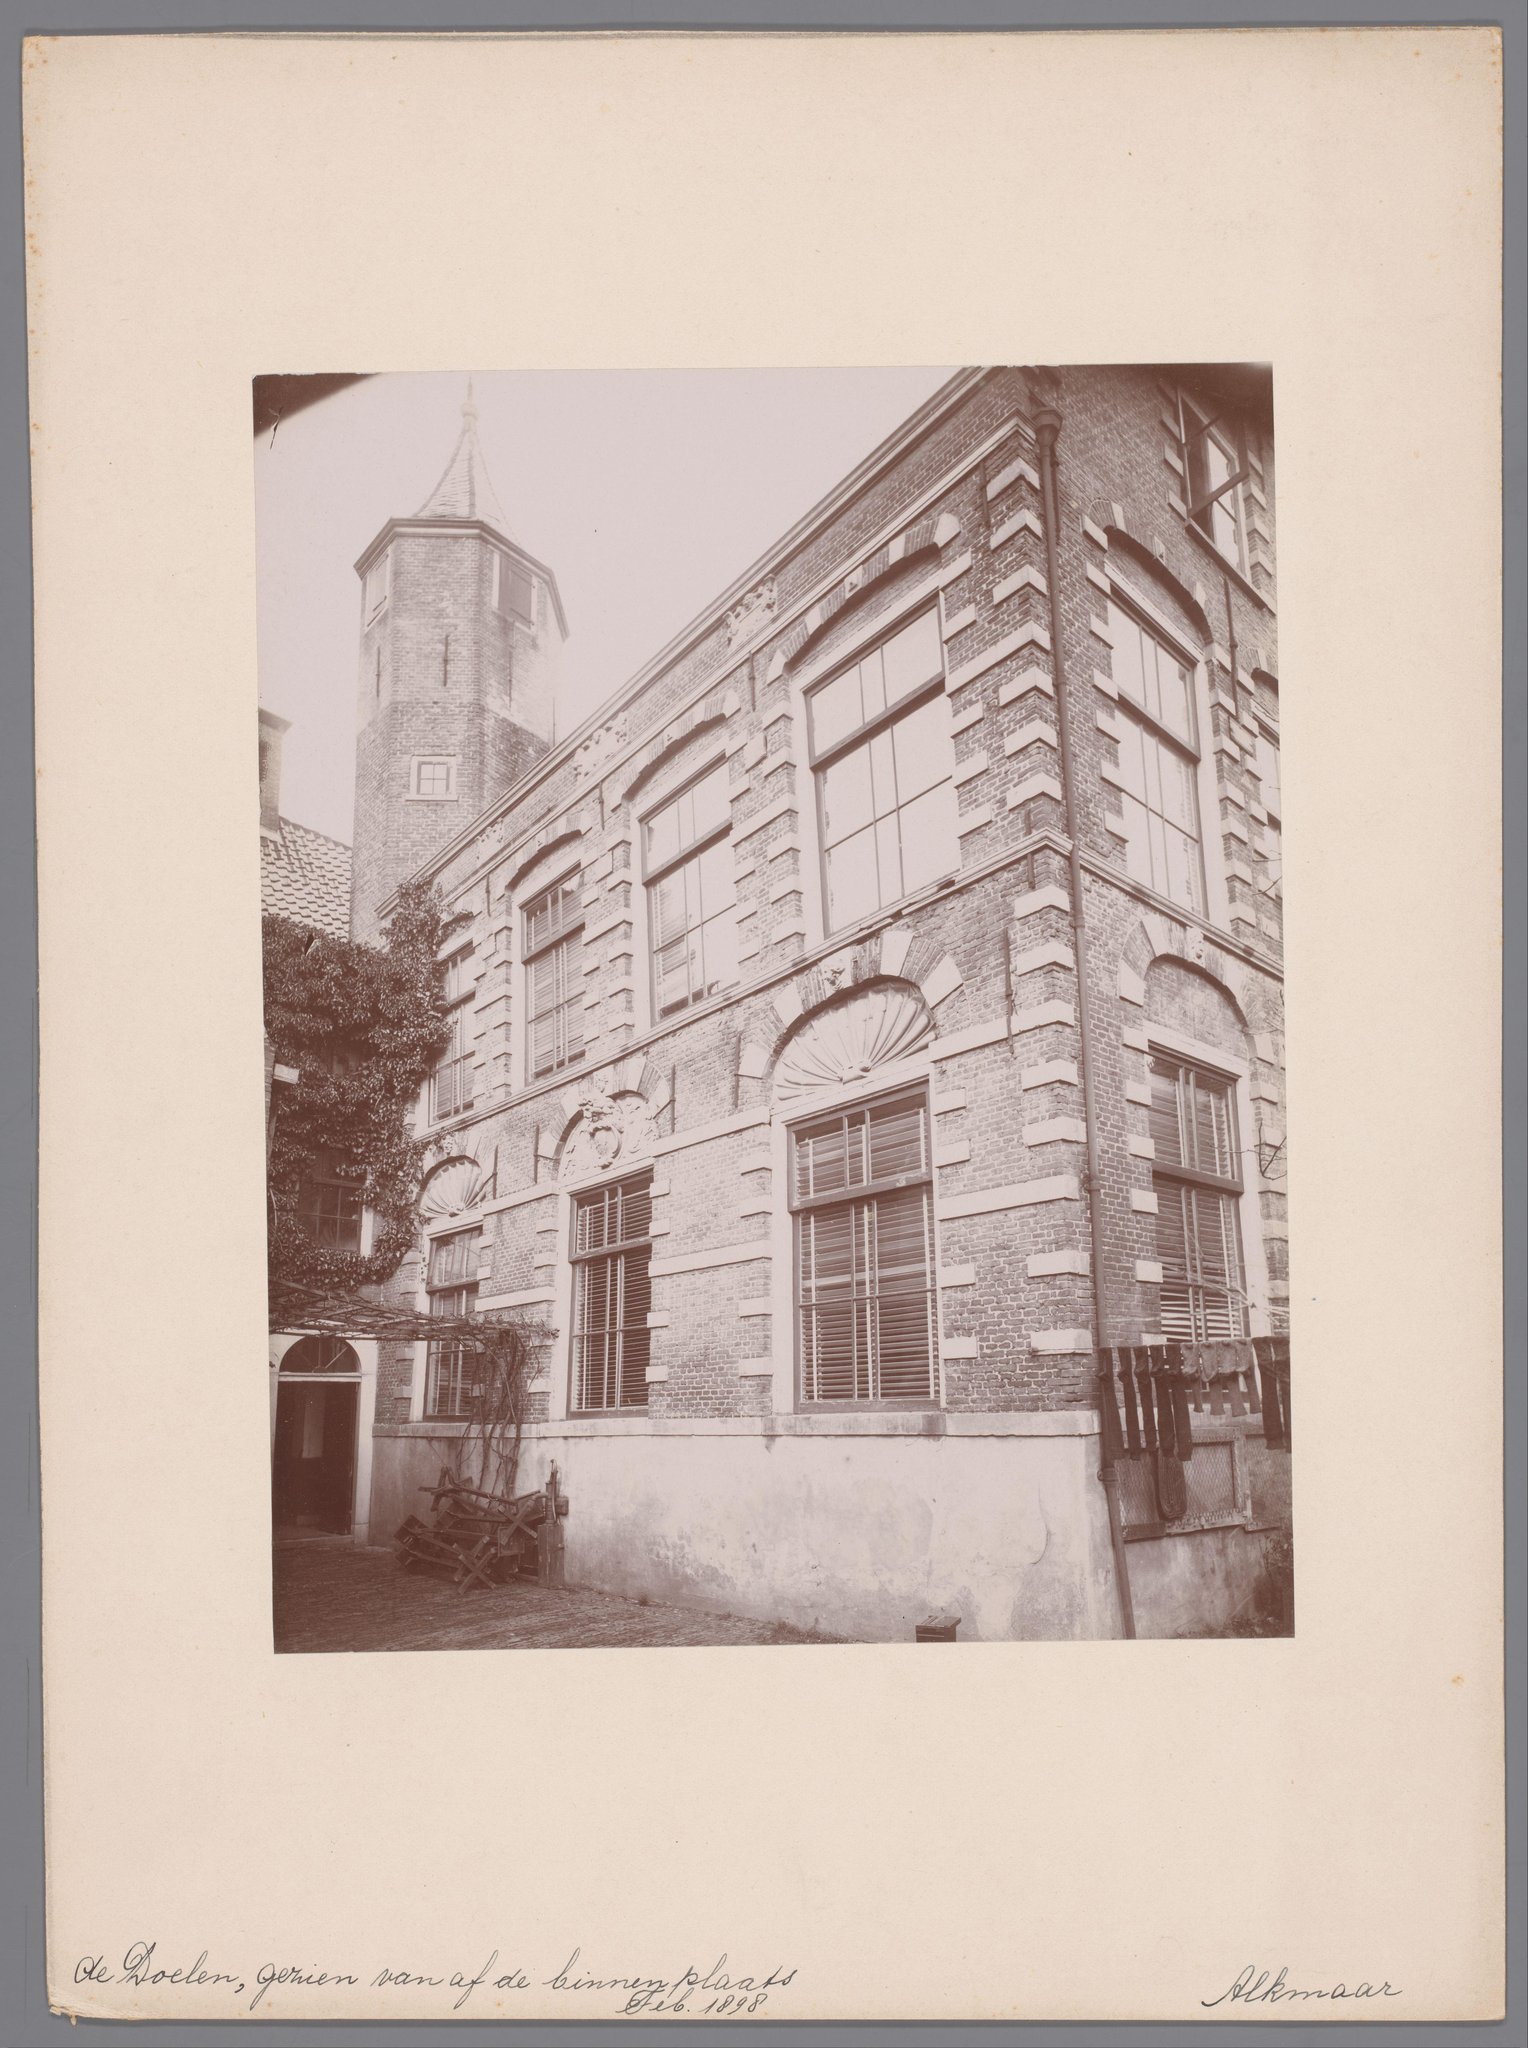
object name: photograph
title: Binnenplaats van de Nieuwe Doelen te Alkmaar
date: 1898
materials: cardboard, paper, photographic support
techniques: gelatin silver print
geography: nieuwe doelen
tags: civic architecture; edifices; dwellings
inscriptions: annotation: ‘Alkmaar (N.H.)/ Doelen gezien van af de binnenplaats/ feb 1898’, annotation: ‘de Doelen, gezien van af de binnenplaats/ Feb. 1898/ Alkmaar’